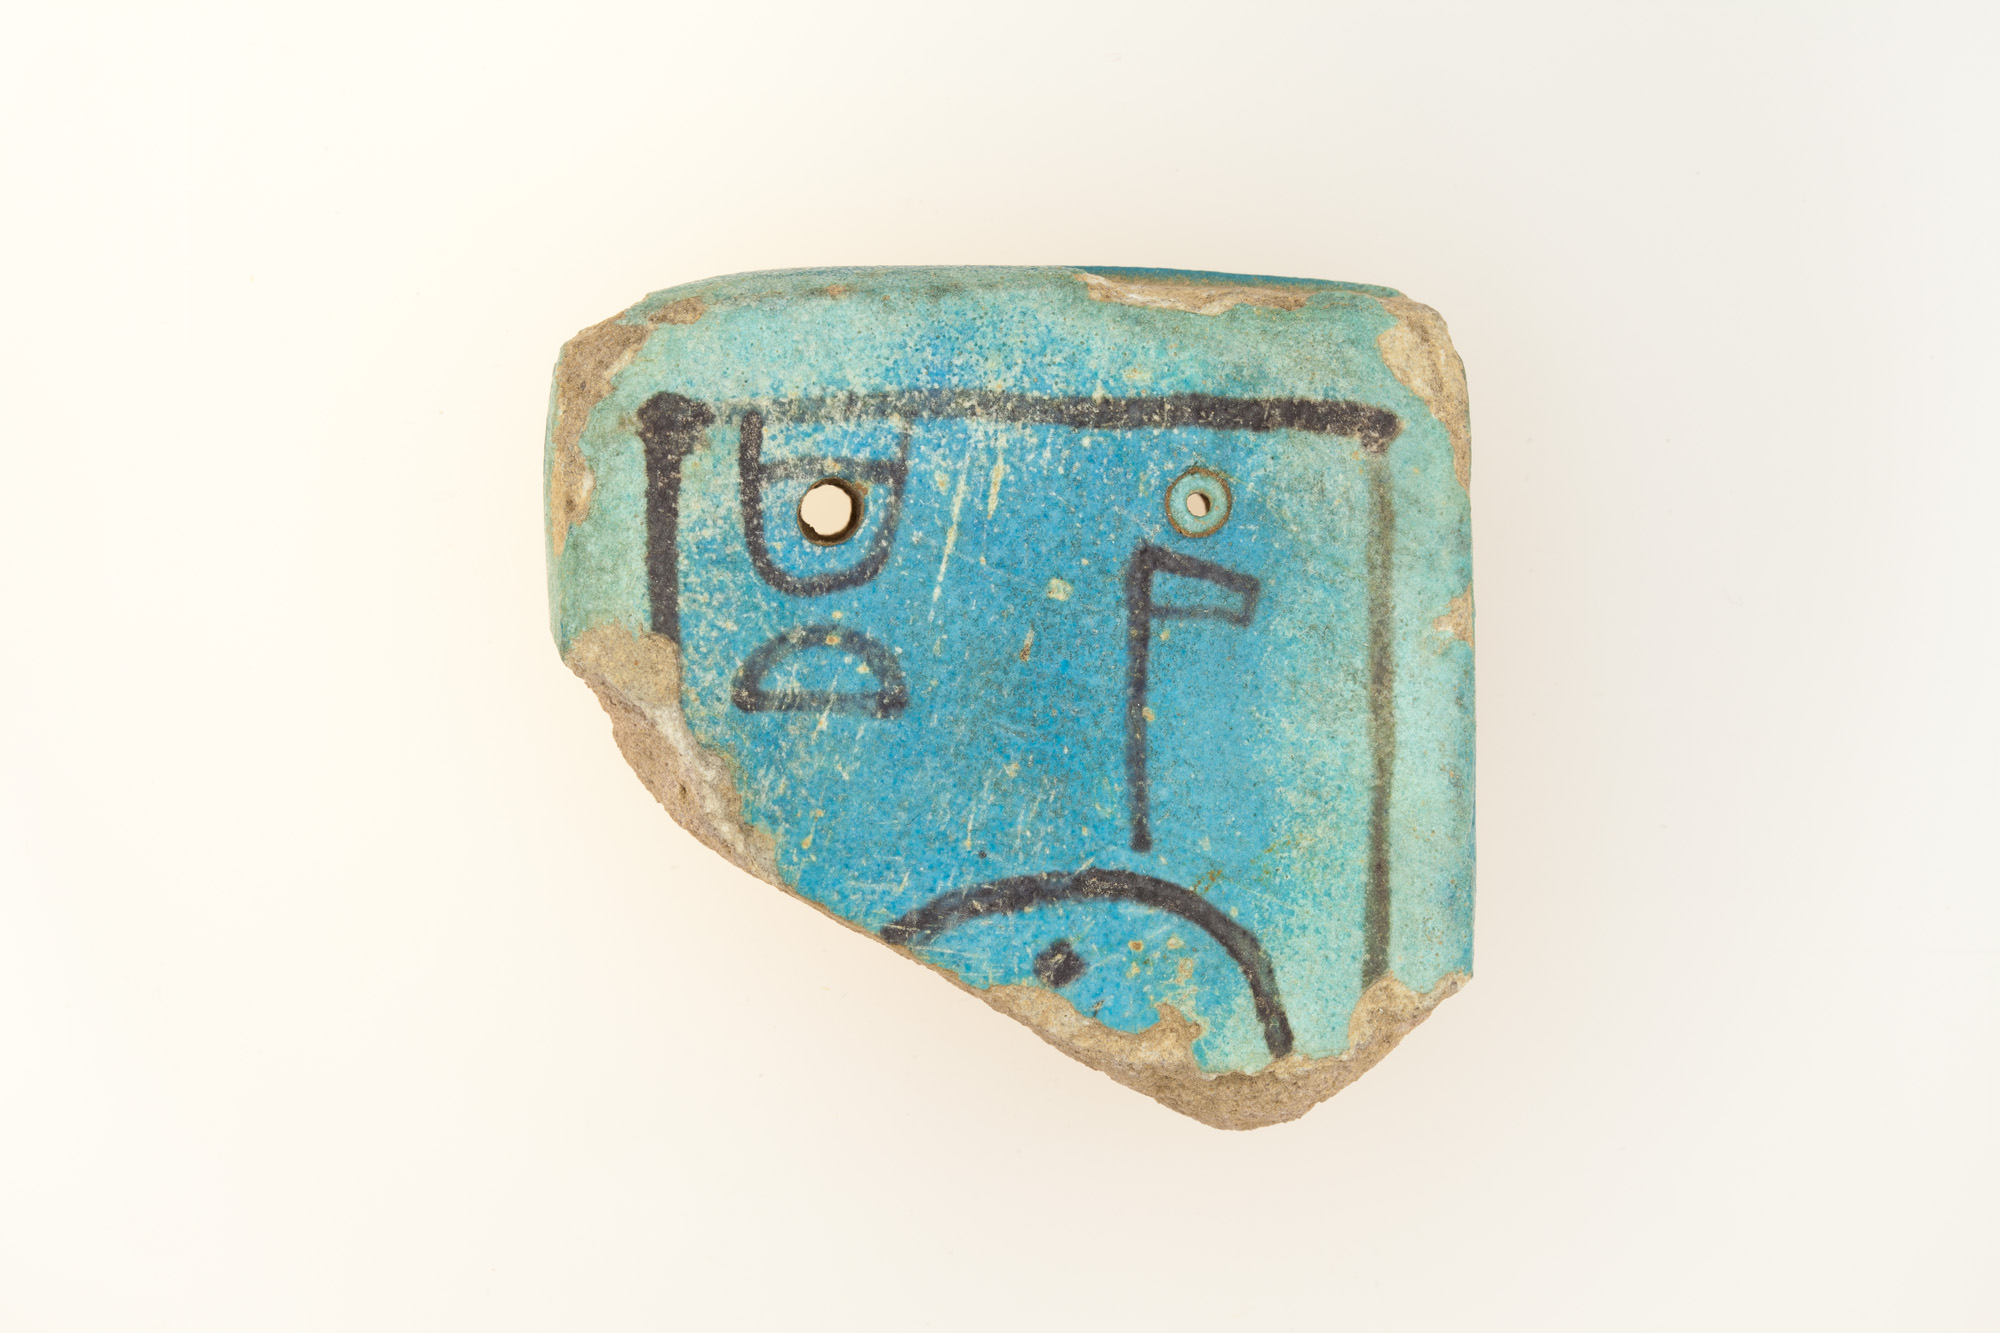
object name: menat fragment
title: Votive Menat fragment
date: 1479-1458 BCE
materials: faience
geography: egypt